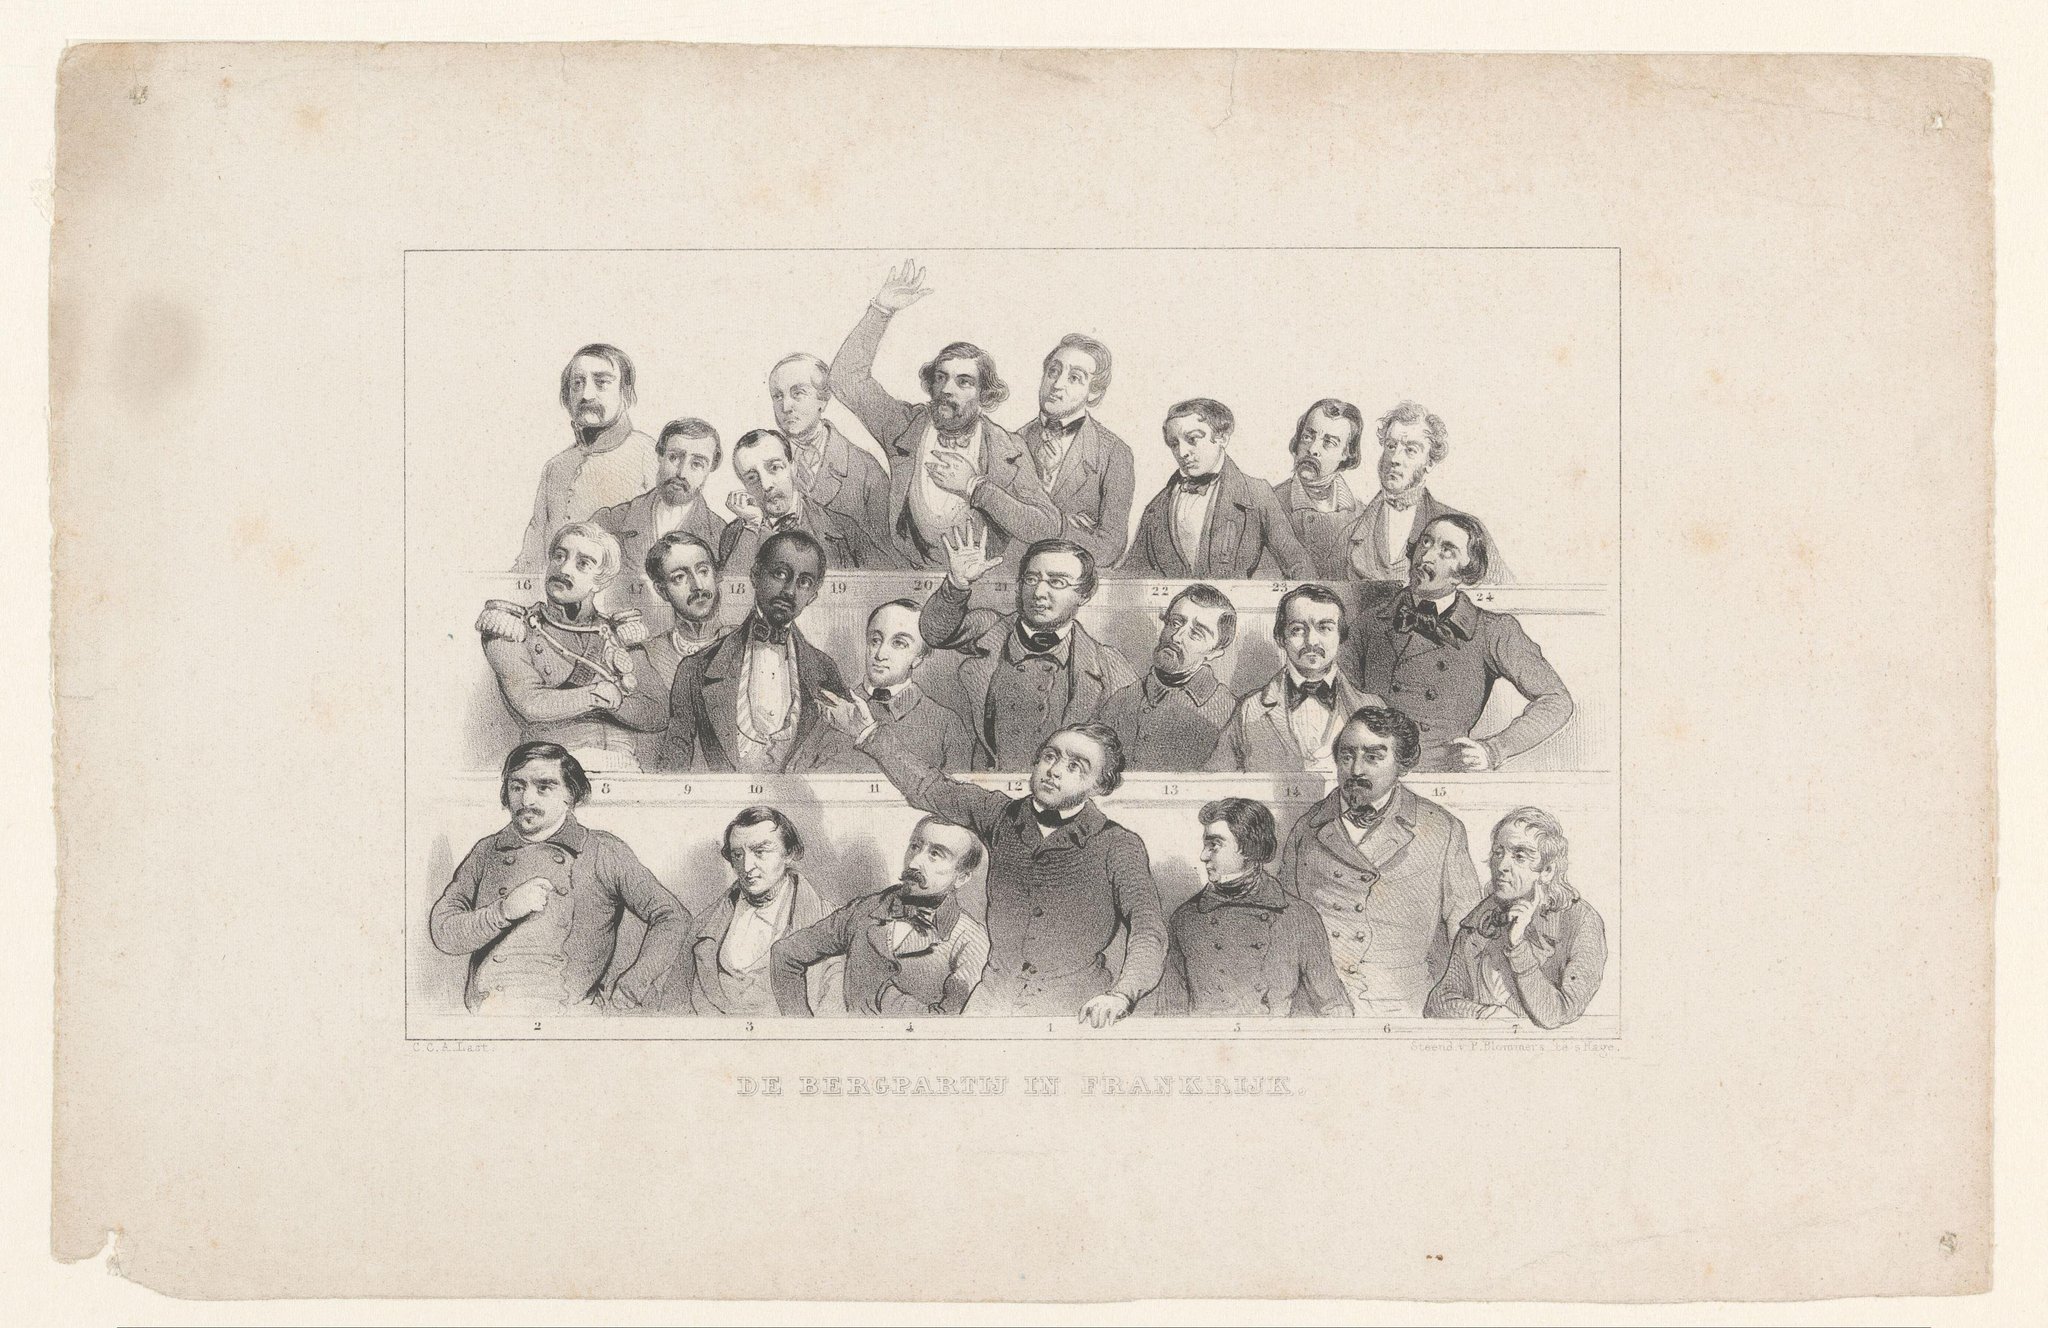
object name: print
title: De Bergpartij in Frankrijk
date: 1842-1887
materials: paper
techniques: lithograph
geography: the hague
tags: member of parliament, lower house, parliament, chamber, france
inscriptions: collector's mark: Lugt 2228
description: Leden van de Bergpartij, de Montagnards, in Frankrijk, ca. 1850. Drie rijen mannen in de banken van de Assemblée Nationale, genummerd 1-24.